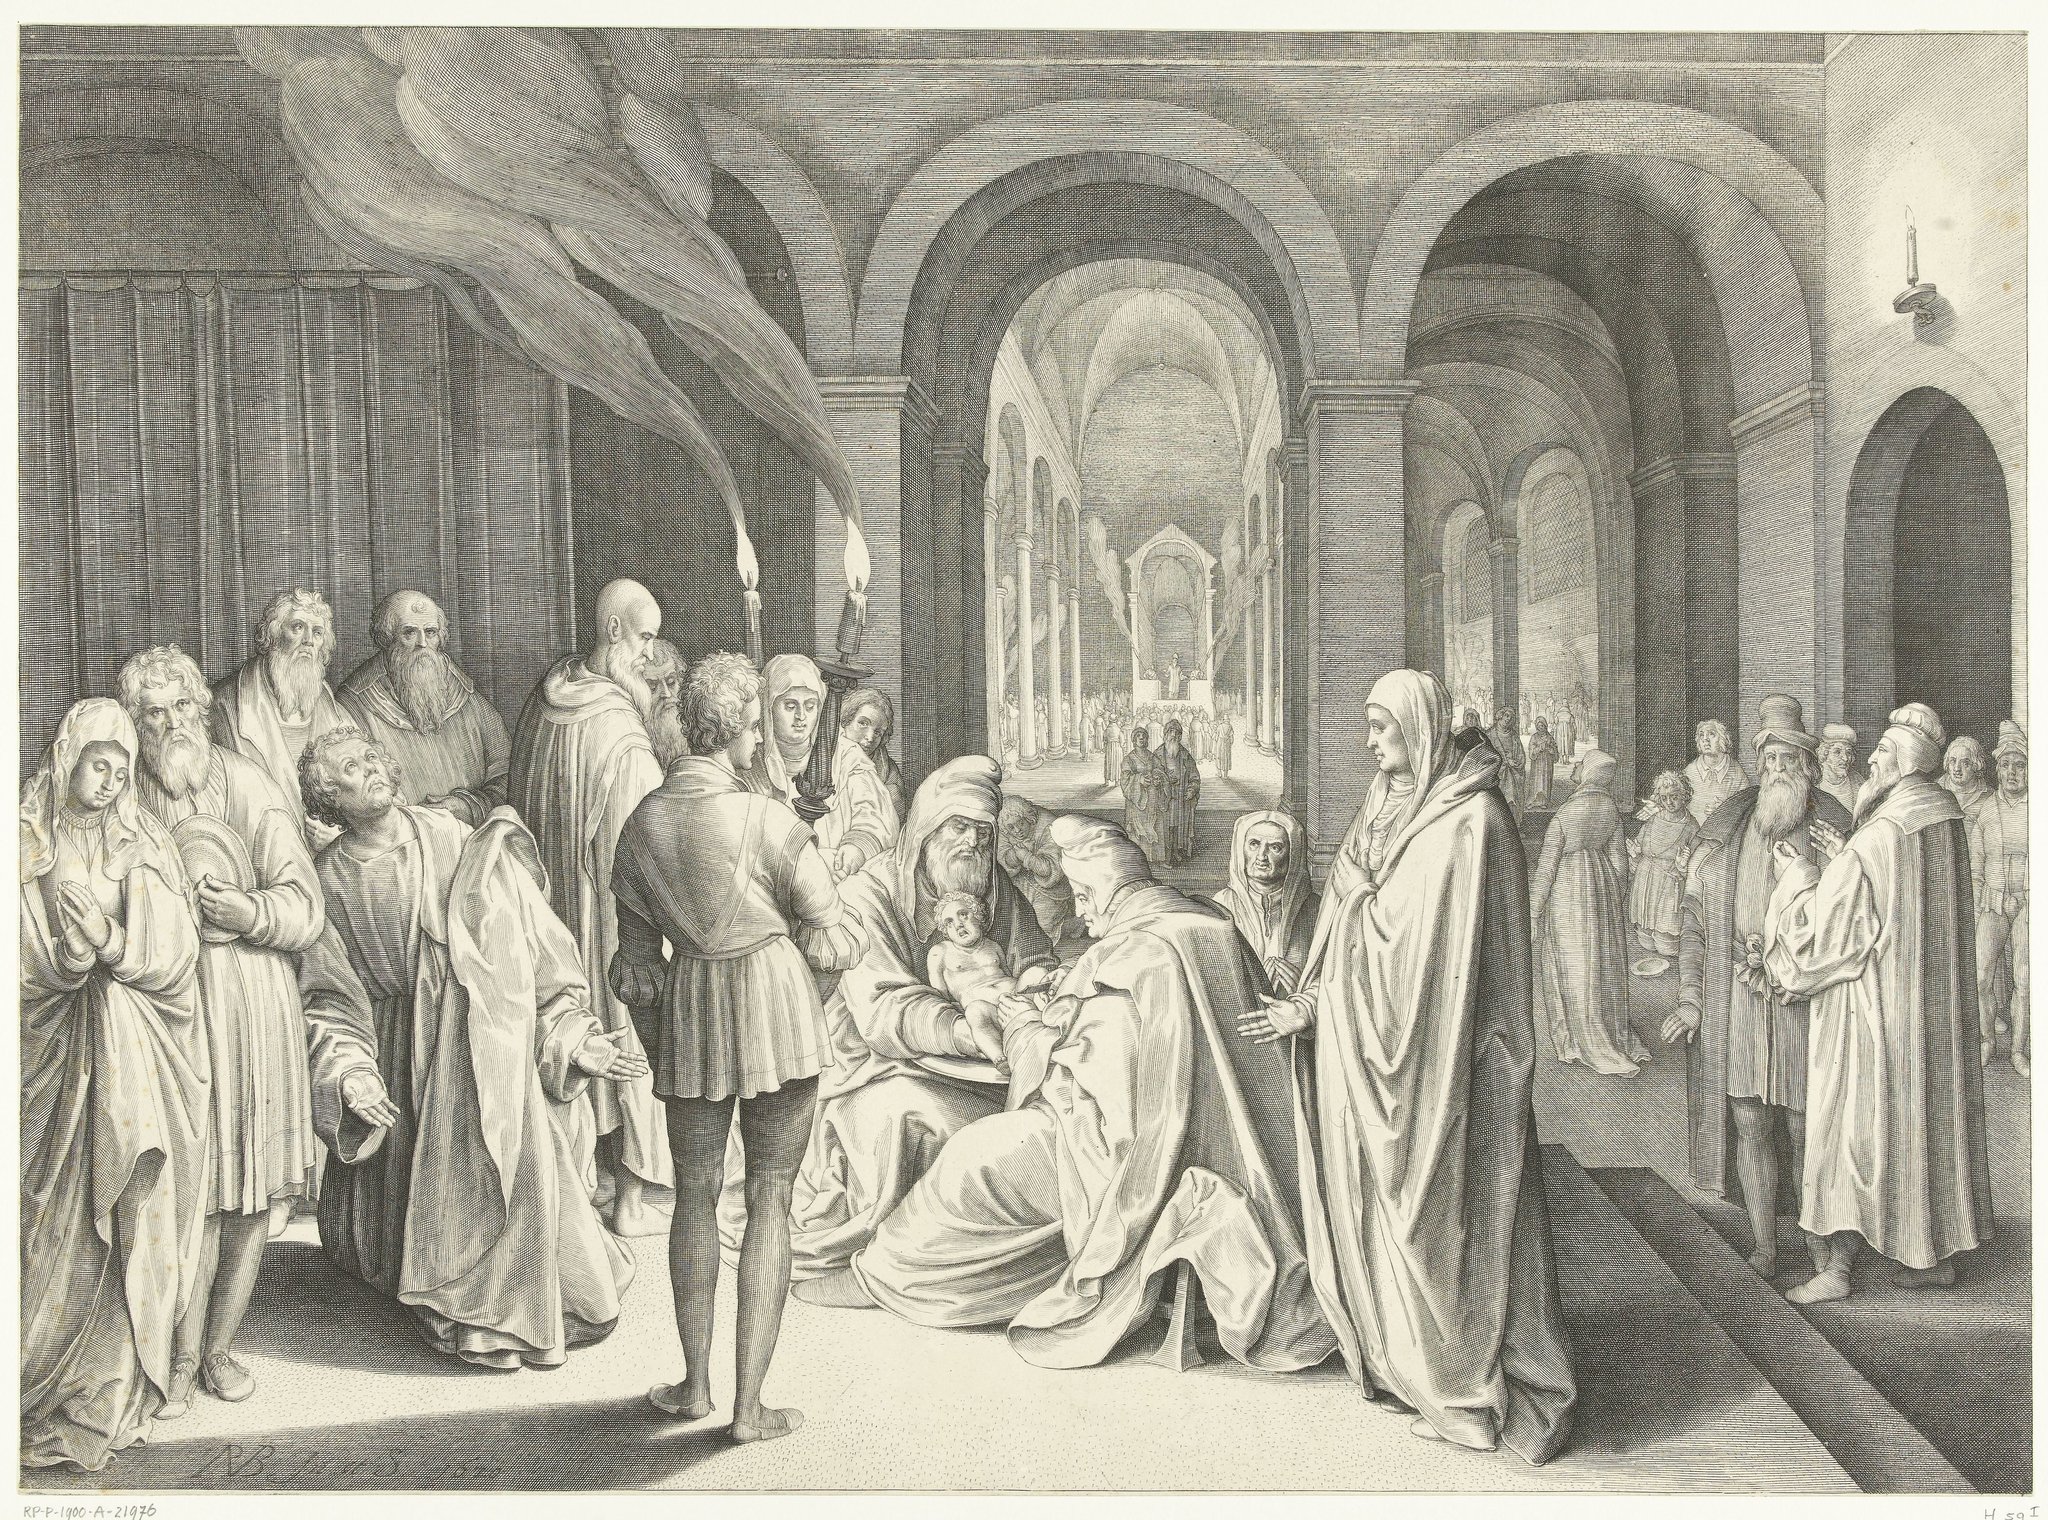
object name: print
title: Besnijdenis van Christus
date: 1620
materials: paper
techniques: engraving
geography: netherlands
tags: circumcision of the christ-child by the priest in the temple (luke 2:21)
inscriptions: collector's mark: Lugt 2228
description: De compositie van Nicolaes de Bruyn is geïnspireerd door het werk van Hendrick Goltzius.